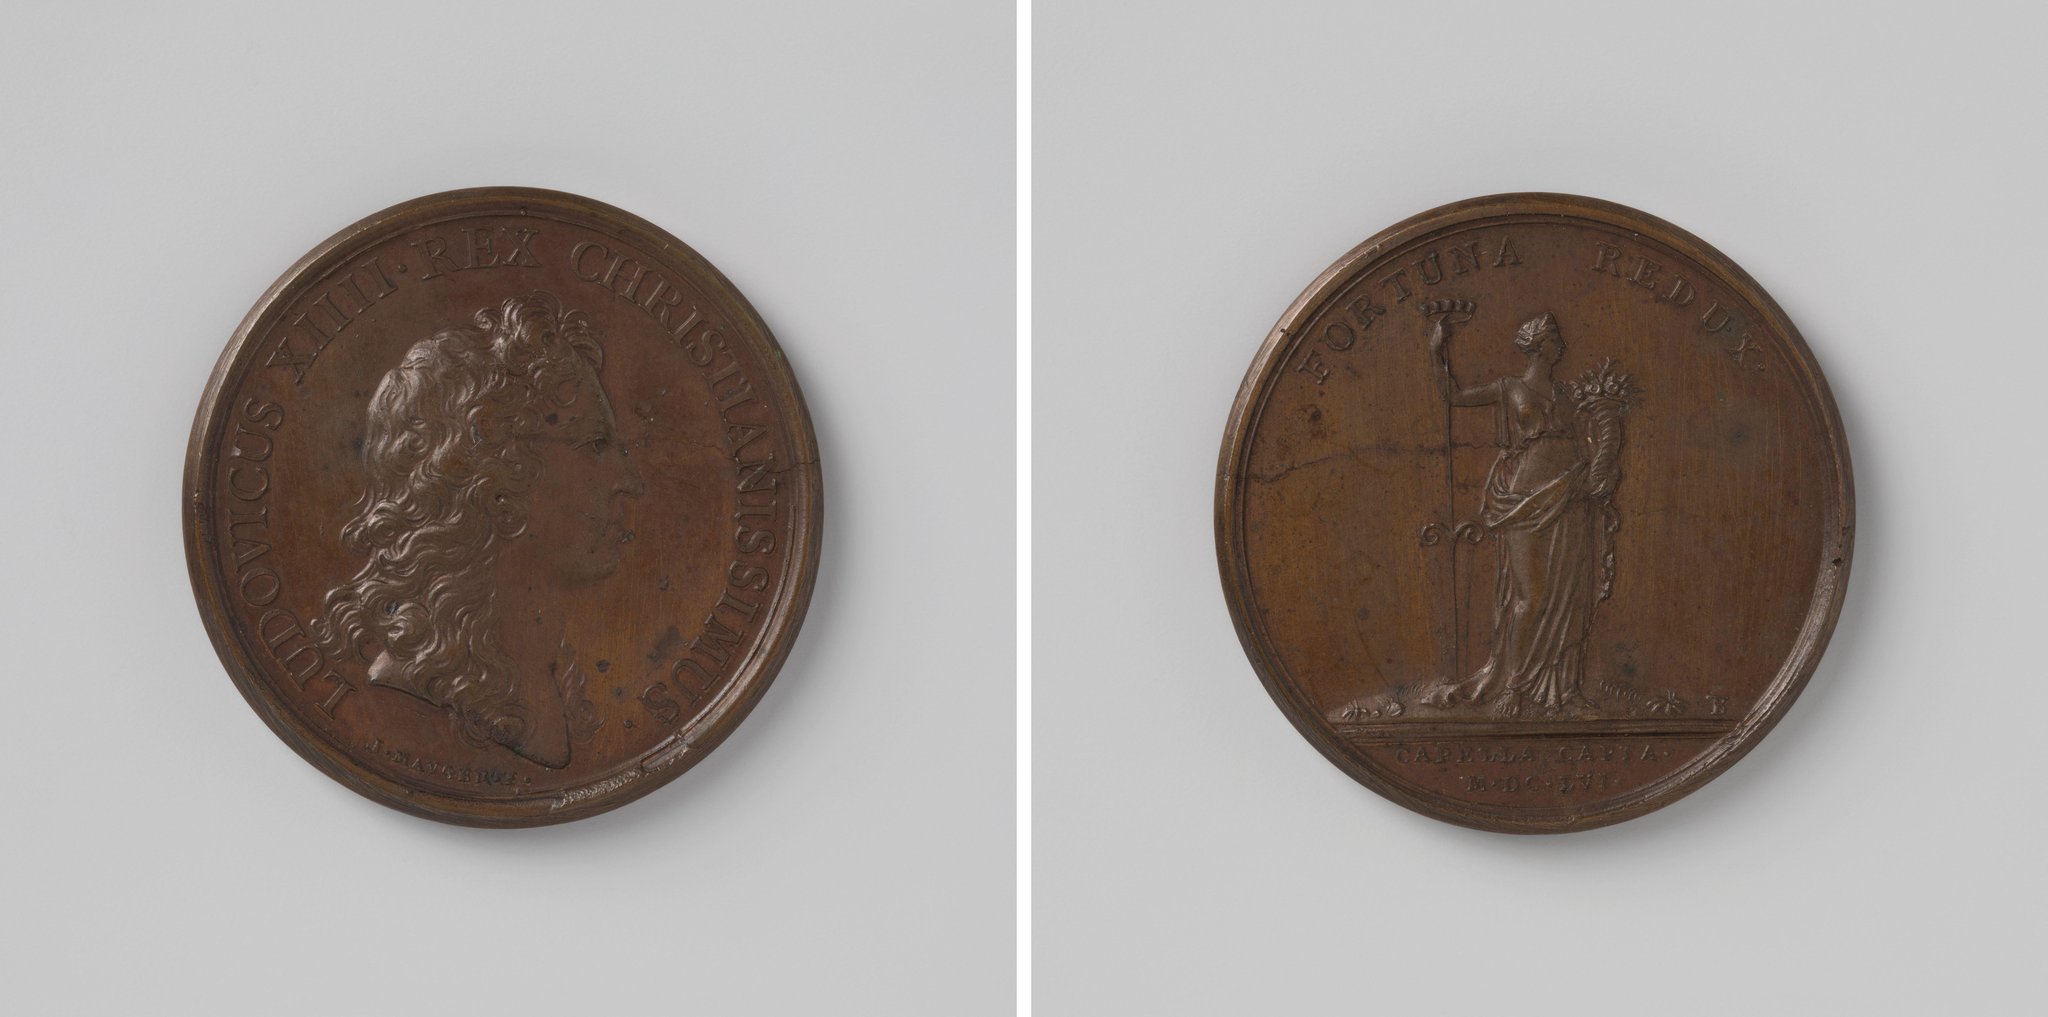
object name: history medal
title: Verovering van La Capelle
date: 1699-1703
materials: bronze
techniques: striking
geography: paris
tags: lodewijk xiv (koning van frankrijk)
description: Bronzen penning. Voorzijde: borststuk jongeman (Lodewijk XIV) binnen omschrift. Keerzijde: Geluk met in linkerhand hoorn van overvloed, in rechterhand scheepsroer met kroon binnen omschrift; afsnede: opschrift.